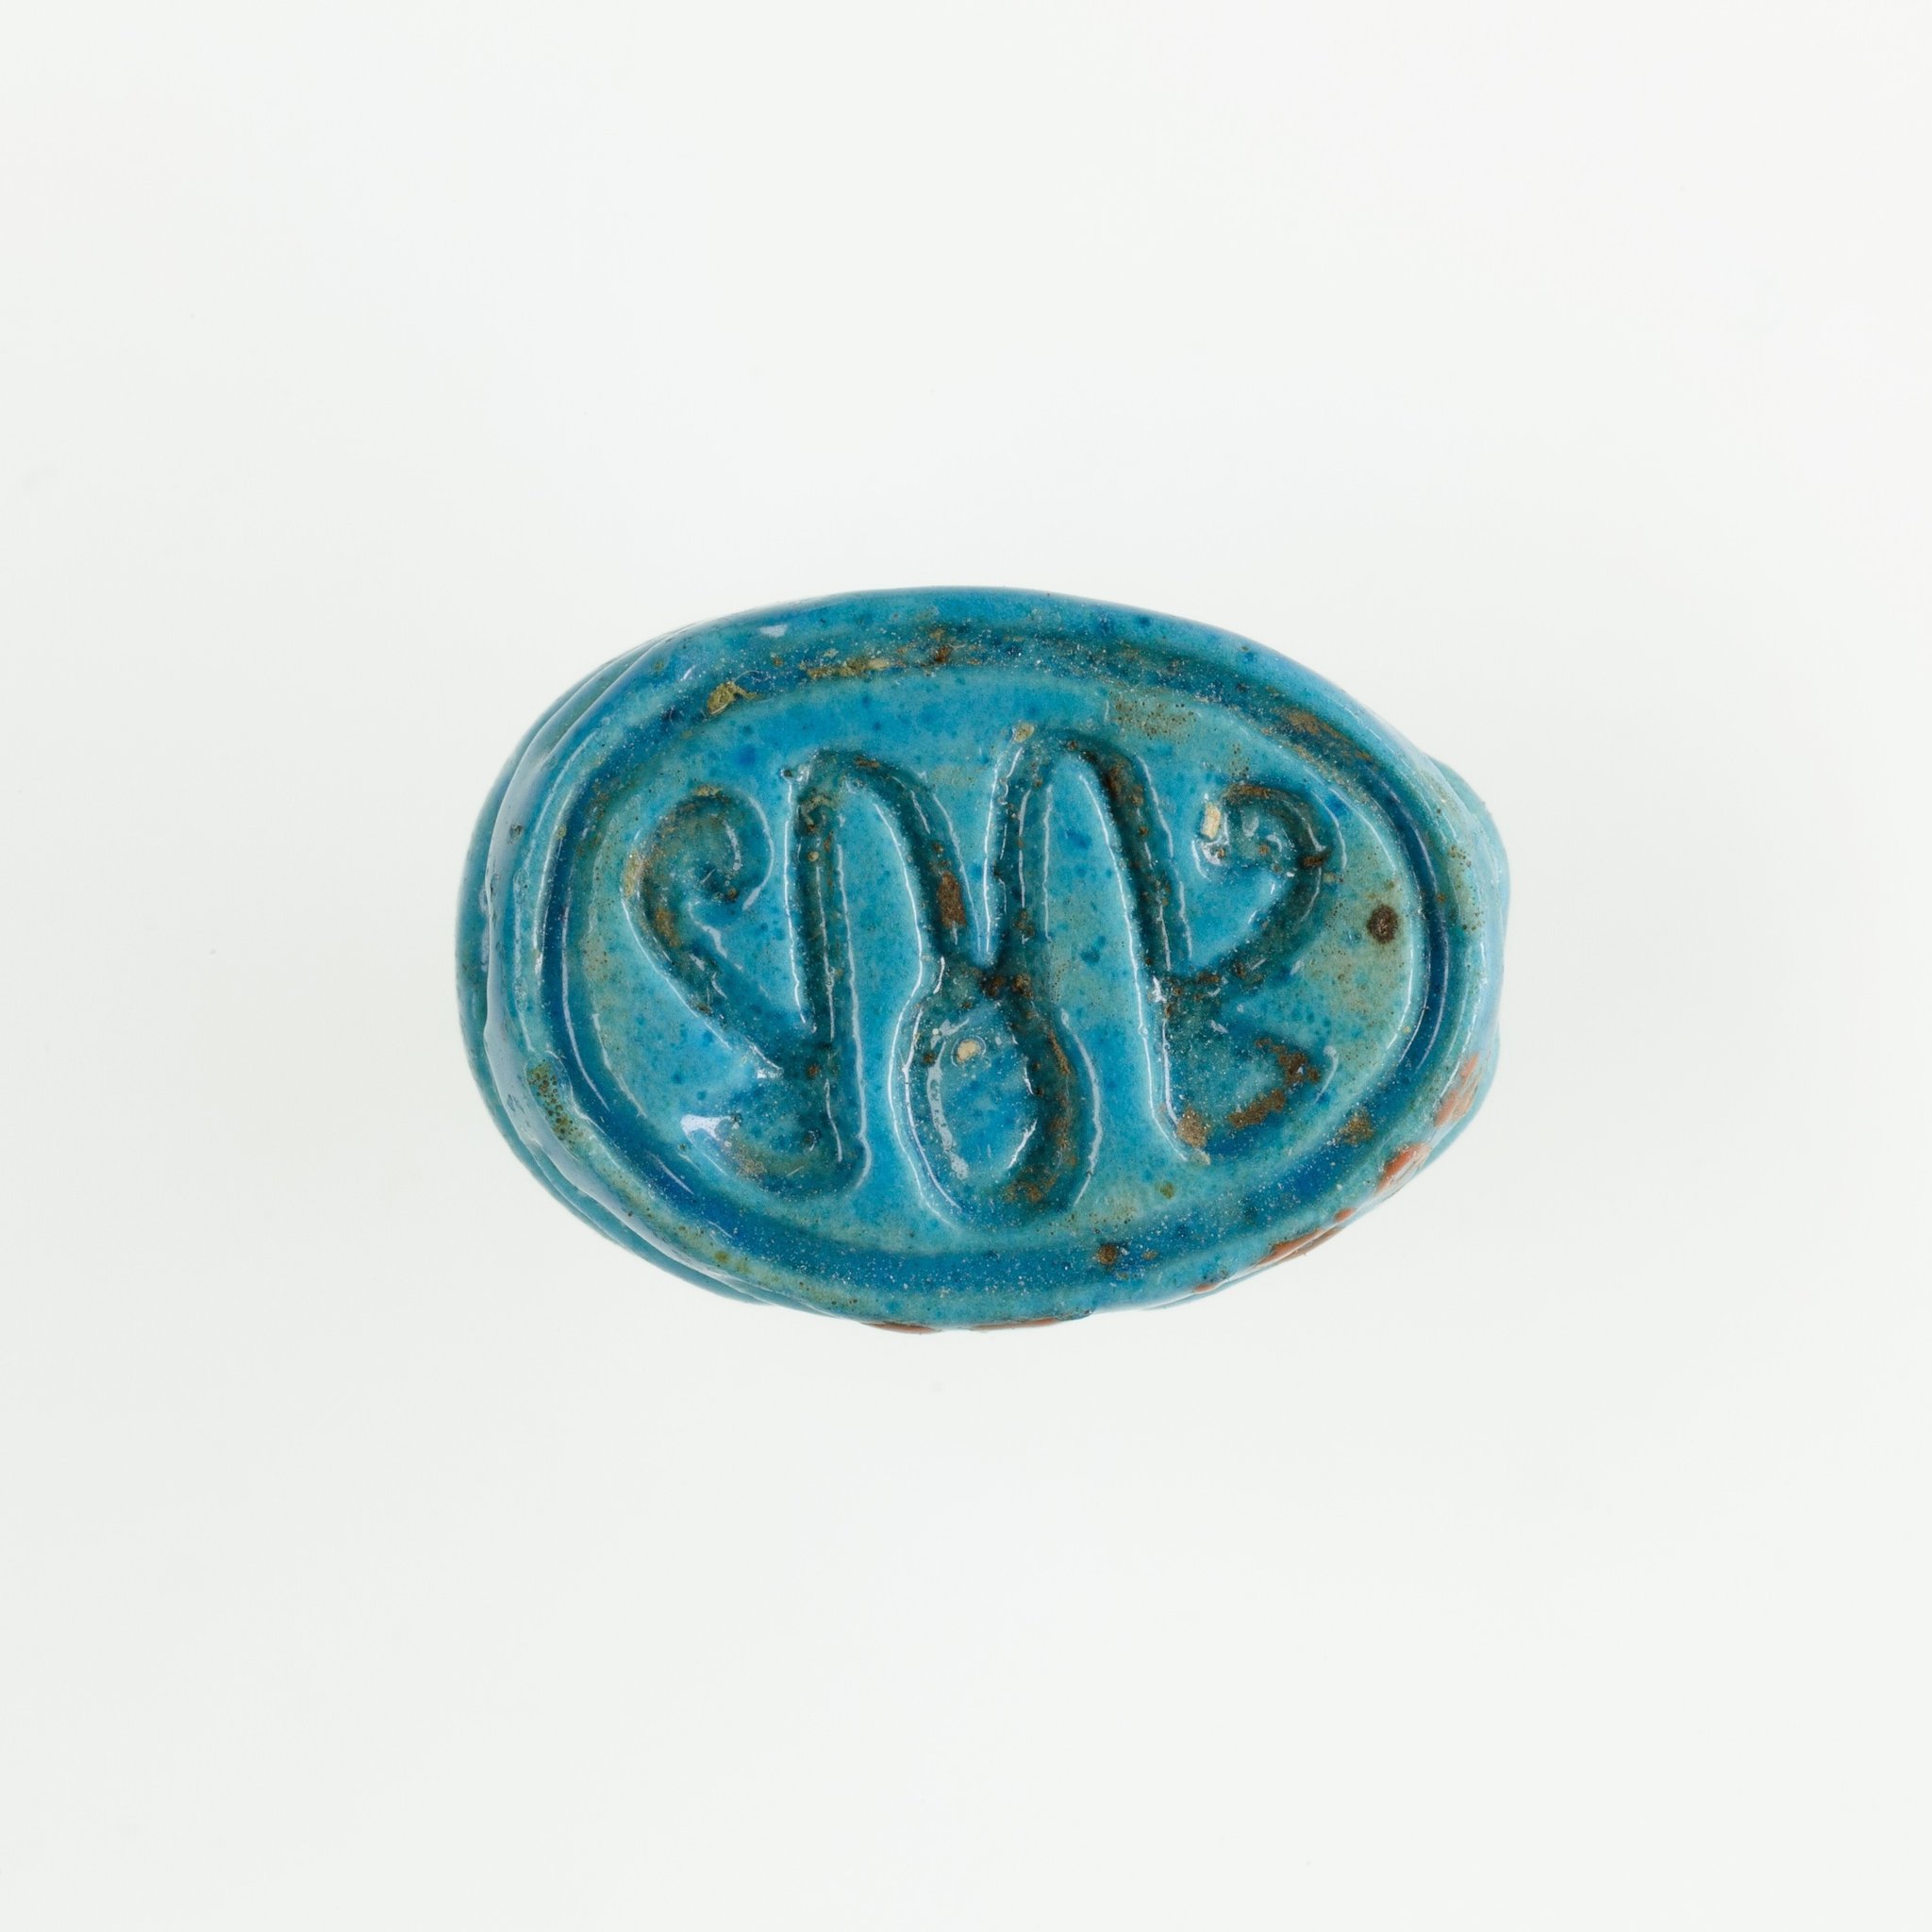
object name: scarab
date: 1492-1473 BCE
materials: faience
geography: egypt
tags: scarabs